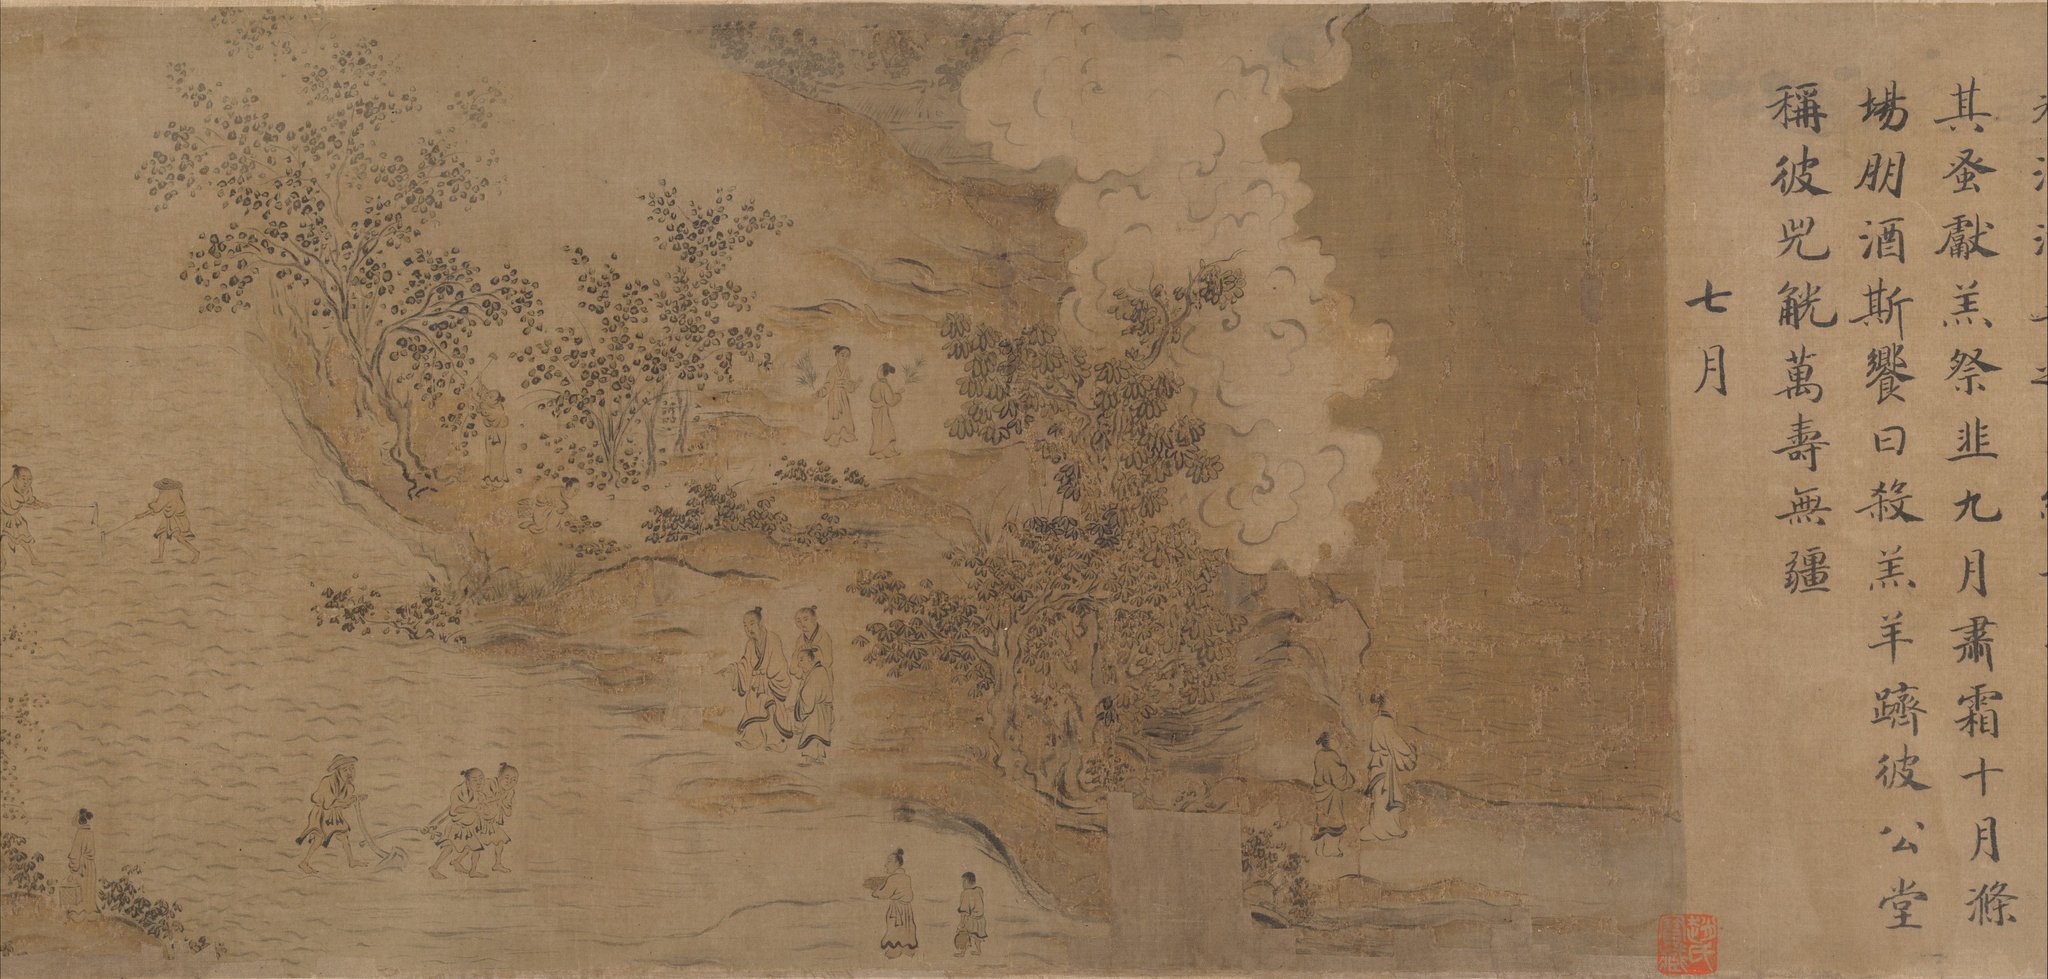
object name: handscroll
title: Odes of the State of Bin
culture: chinese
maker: ma hezhi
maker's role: artist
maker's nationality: chinese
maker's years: 1130-1170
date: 1134-1166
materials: gold, ink, silk, silver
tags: men,landscapes